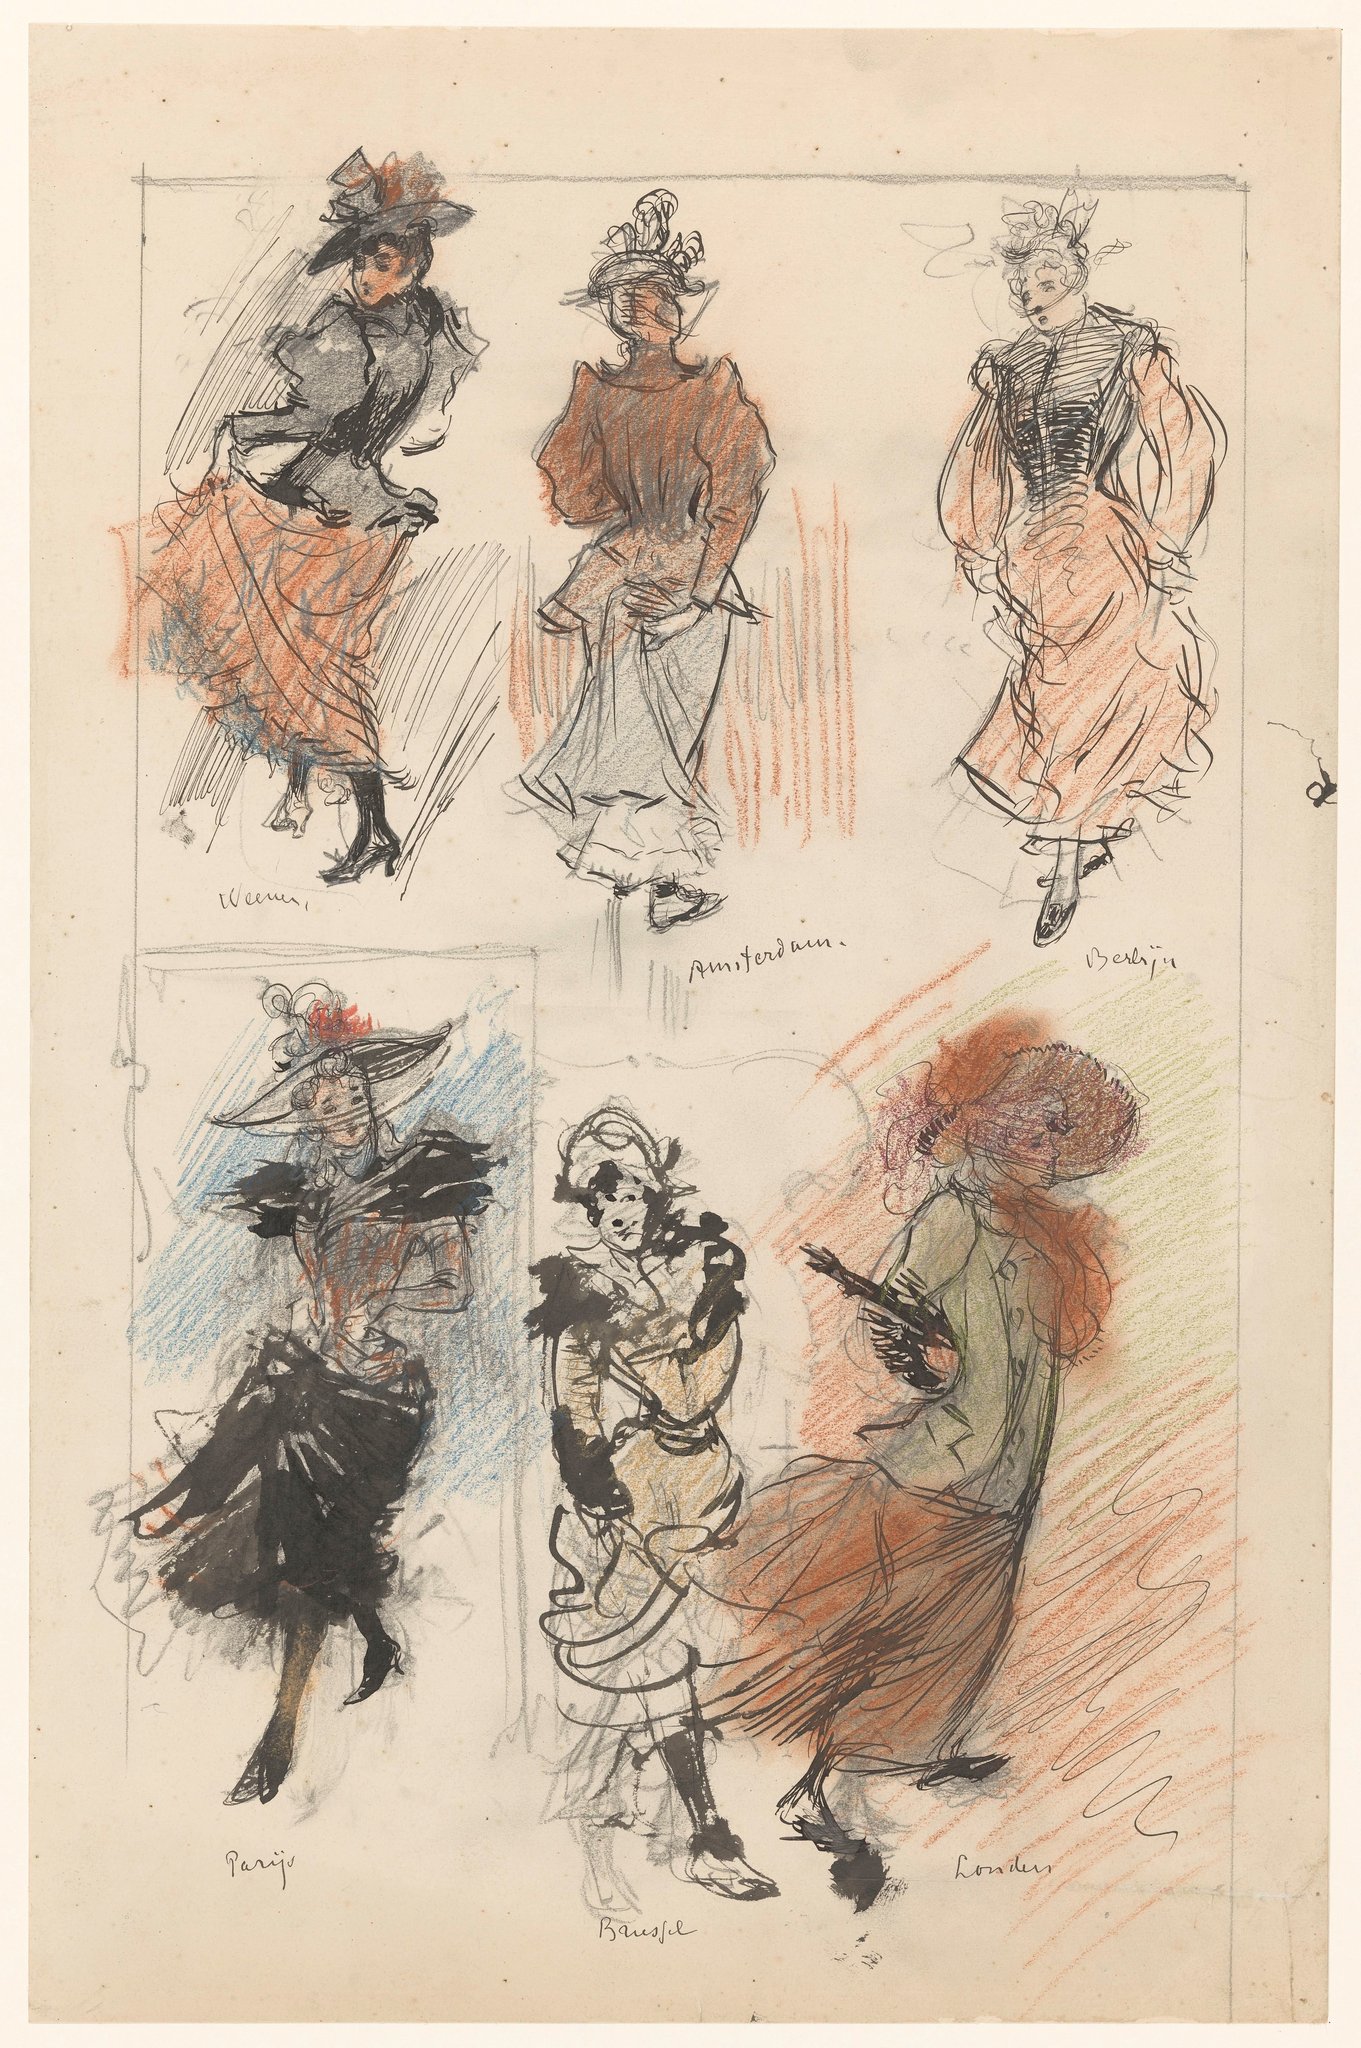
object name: drawing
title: Vergelijking tussen zes vrouwen uit de Europese hoofdsteden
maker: henricus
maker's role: draughtsman, print maker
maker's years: 1867-1921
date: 1877-1921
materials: chalk, ink, paper, pencil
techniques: brush, pen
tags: fashion